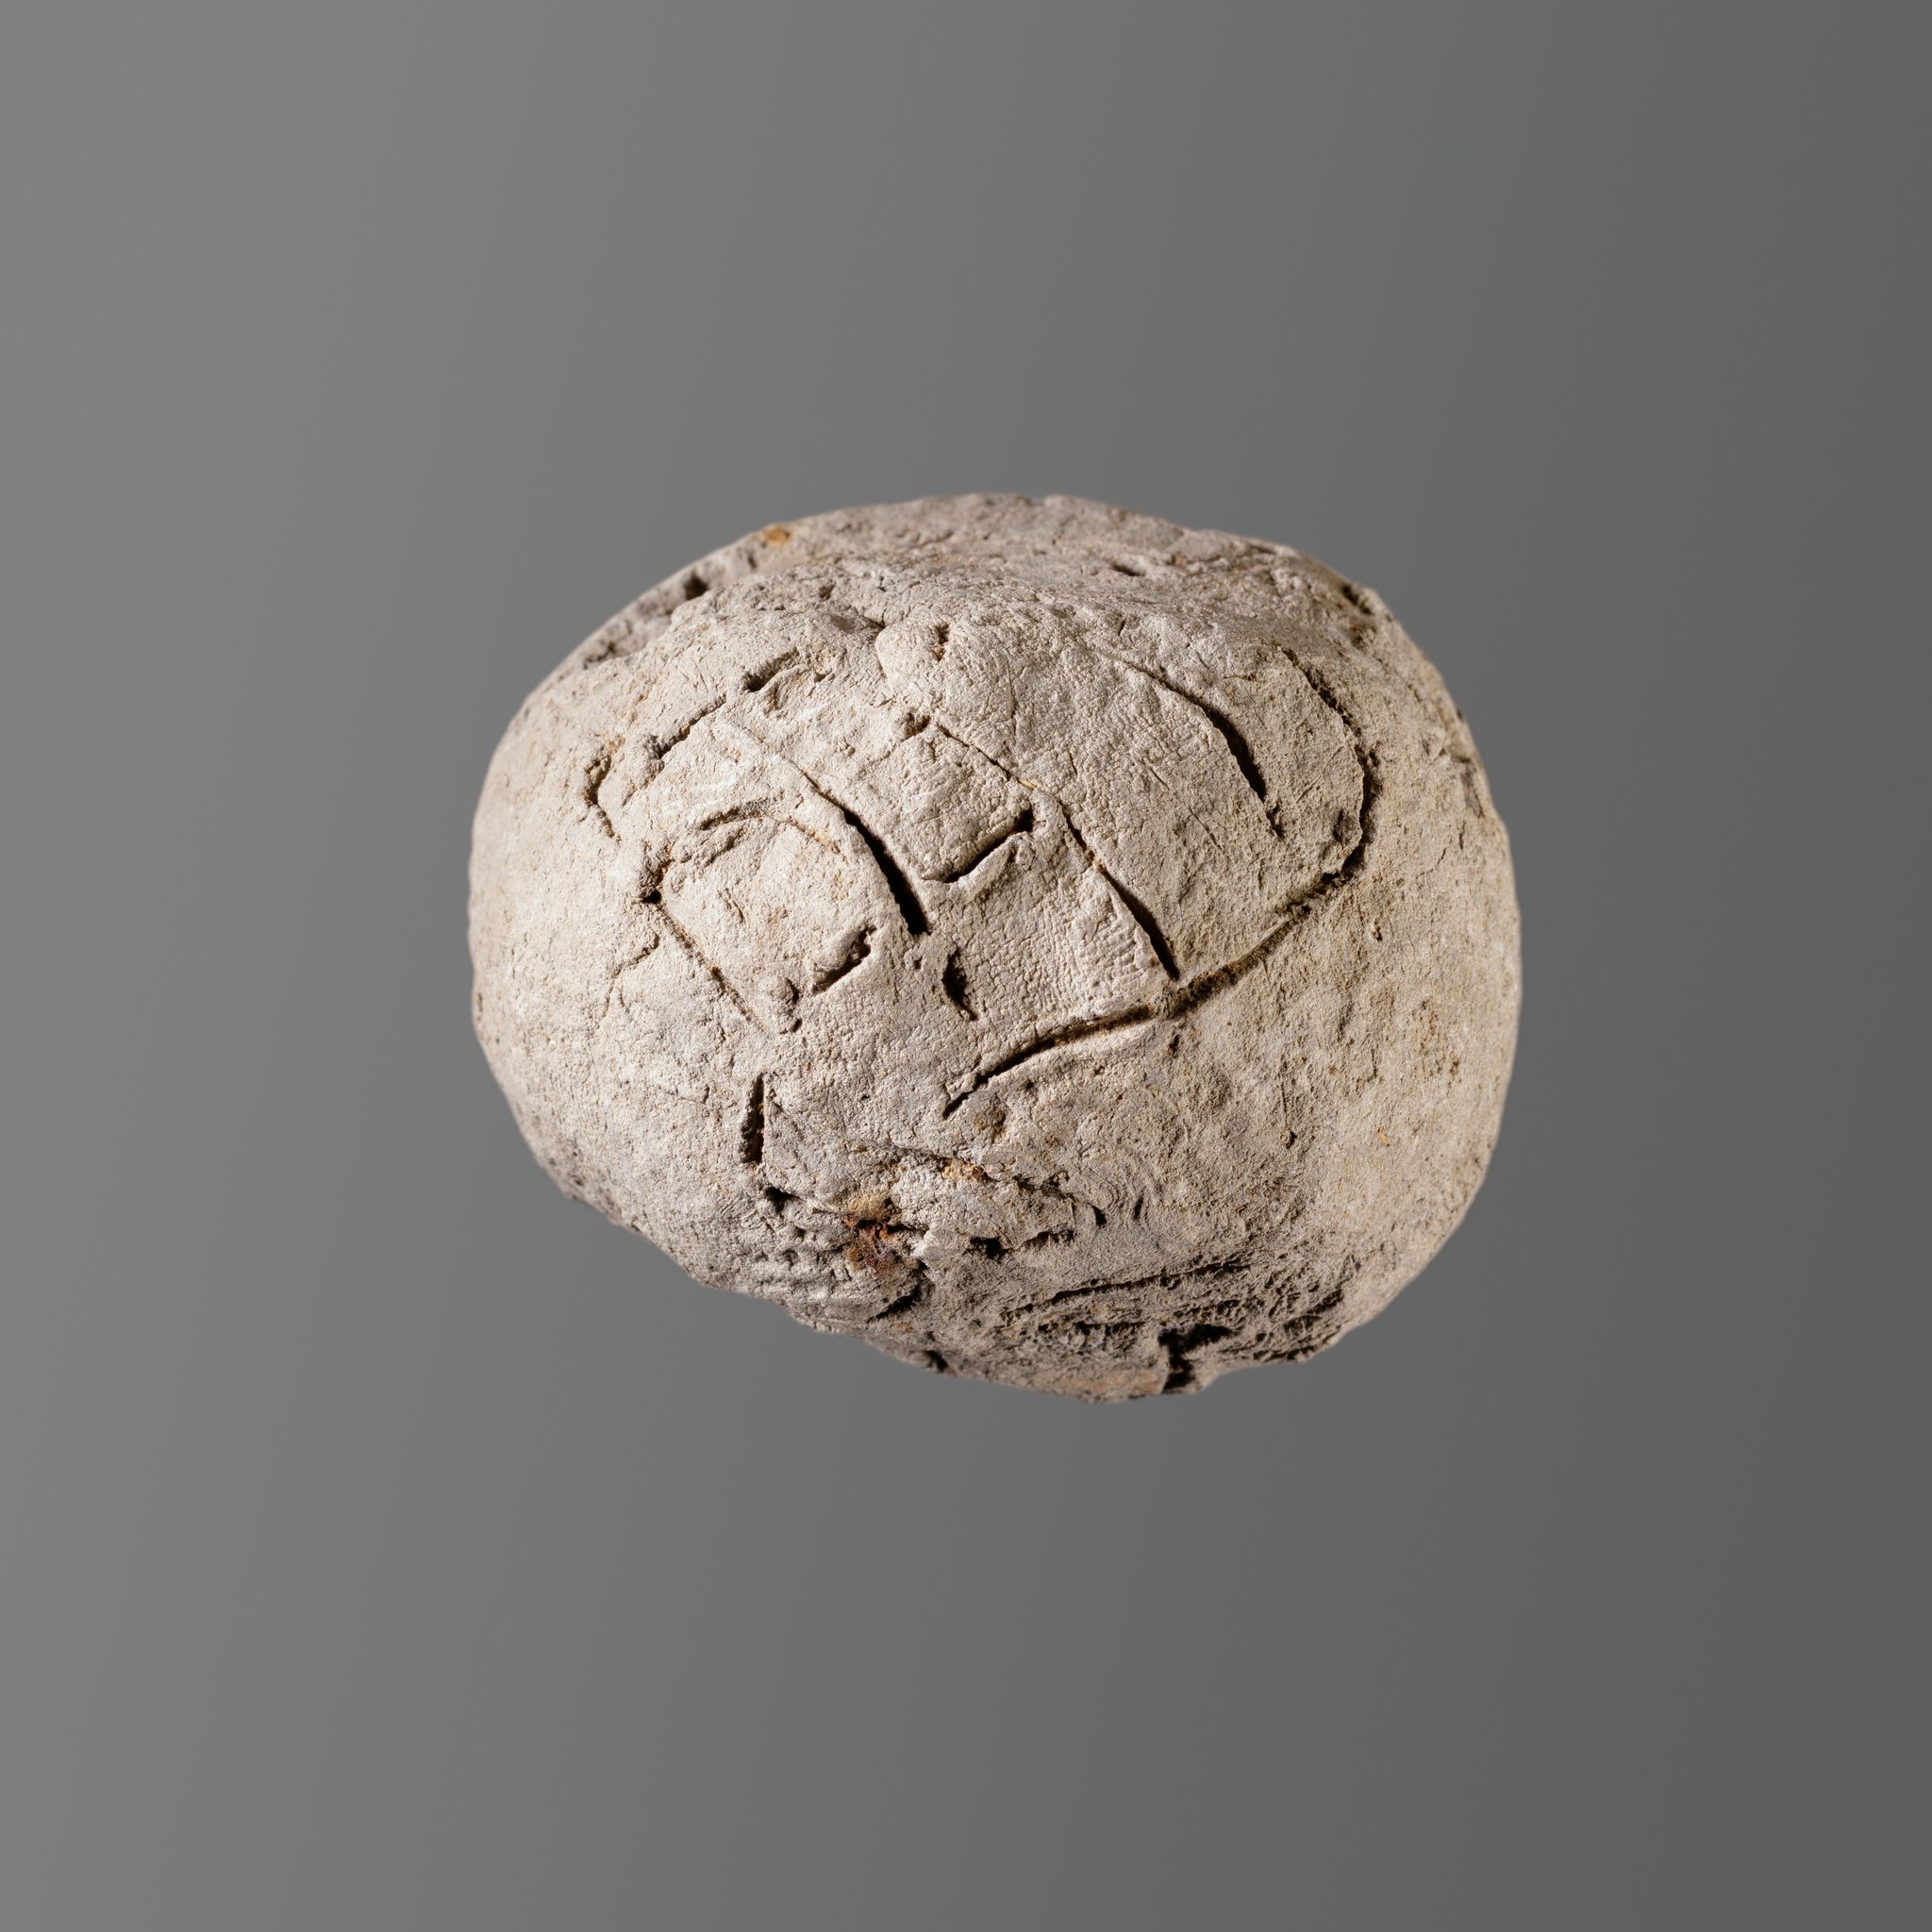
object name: ball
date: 2649-2465 BCE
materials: clay, mud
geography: egypt